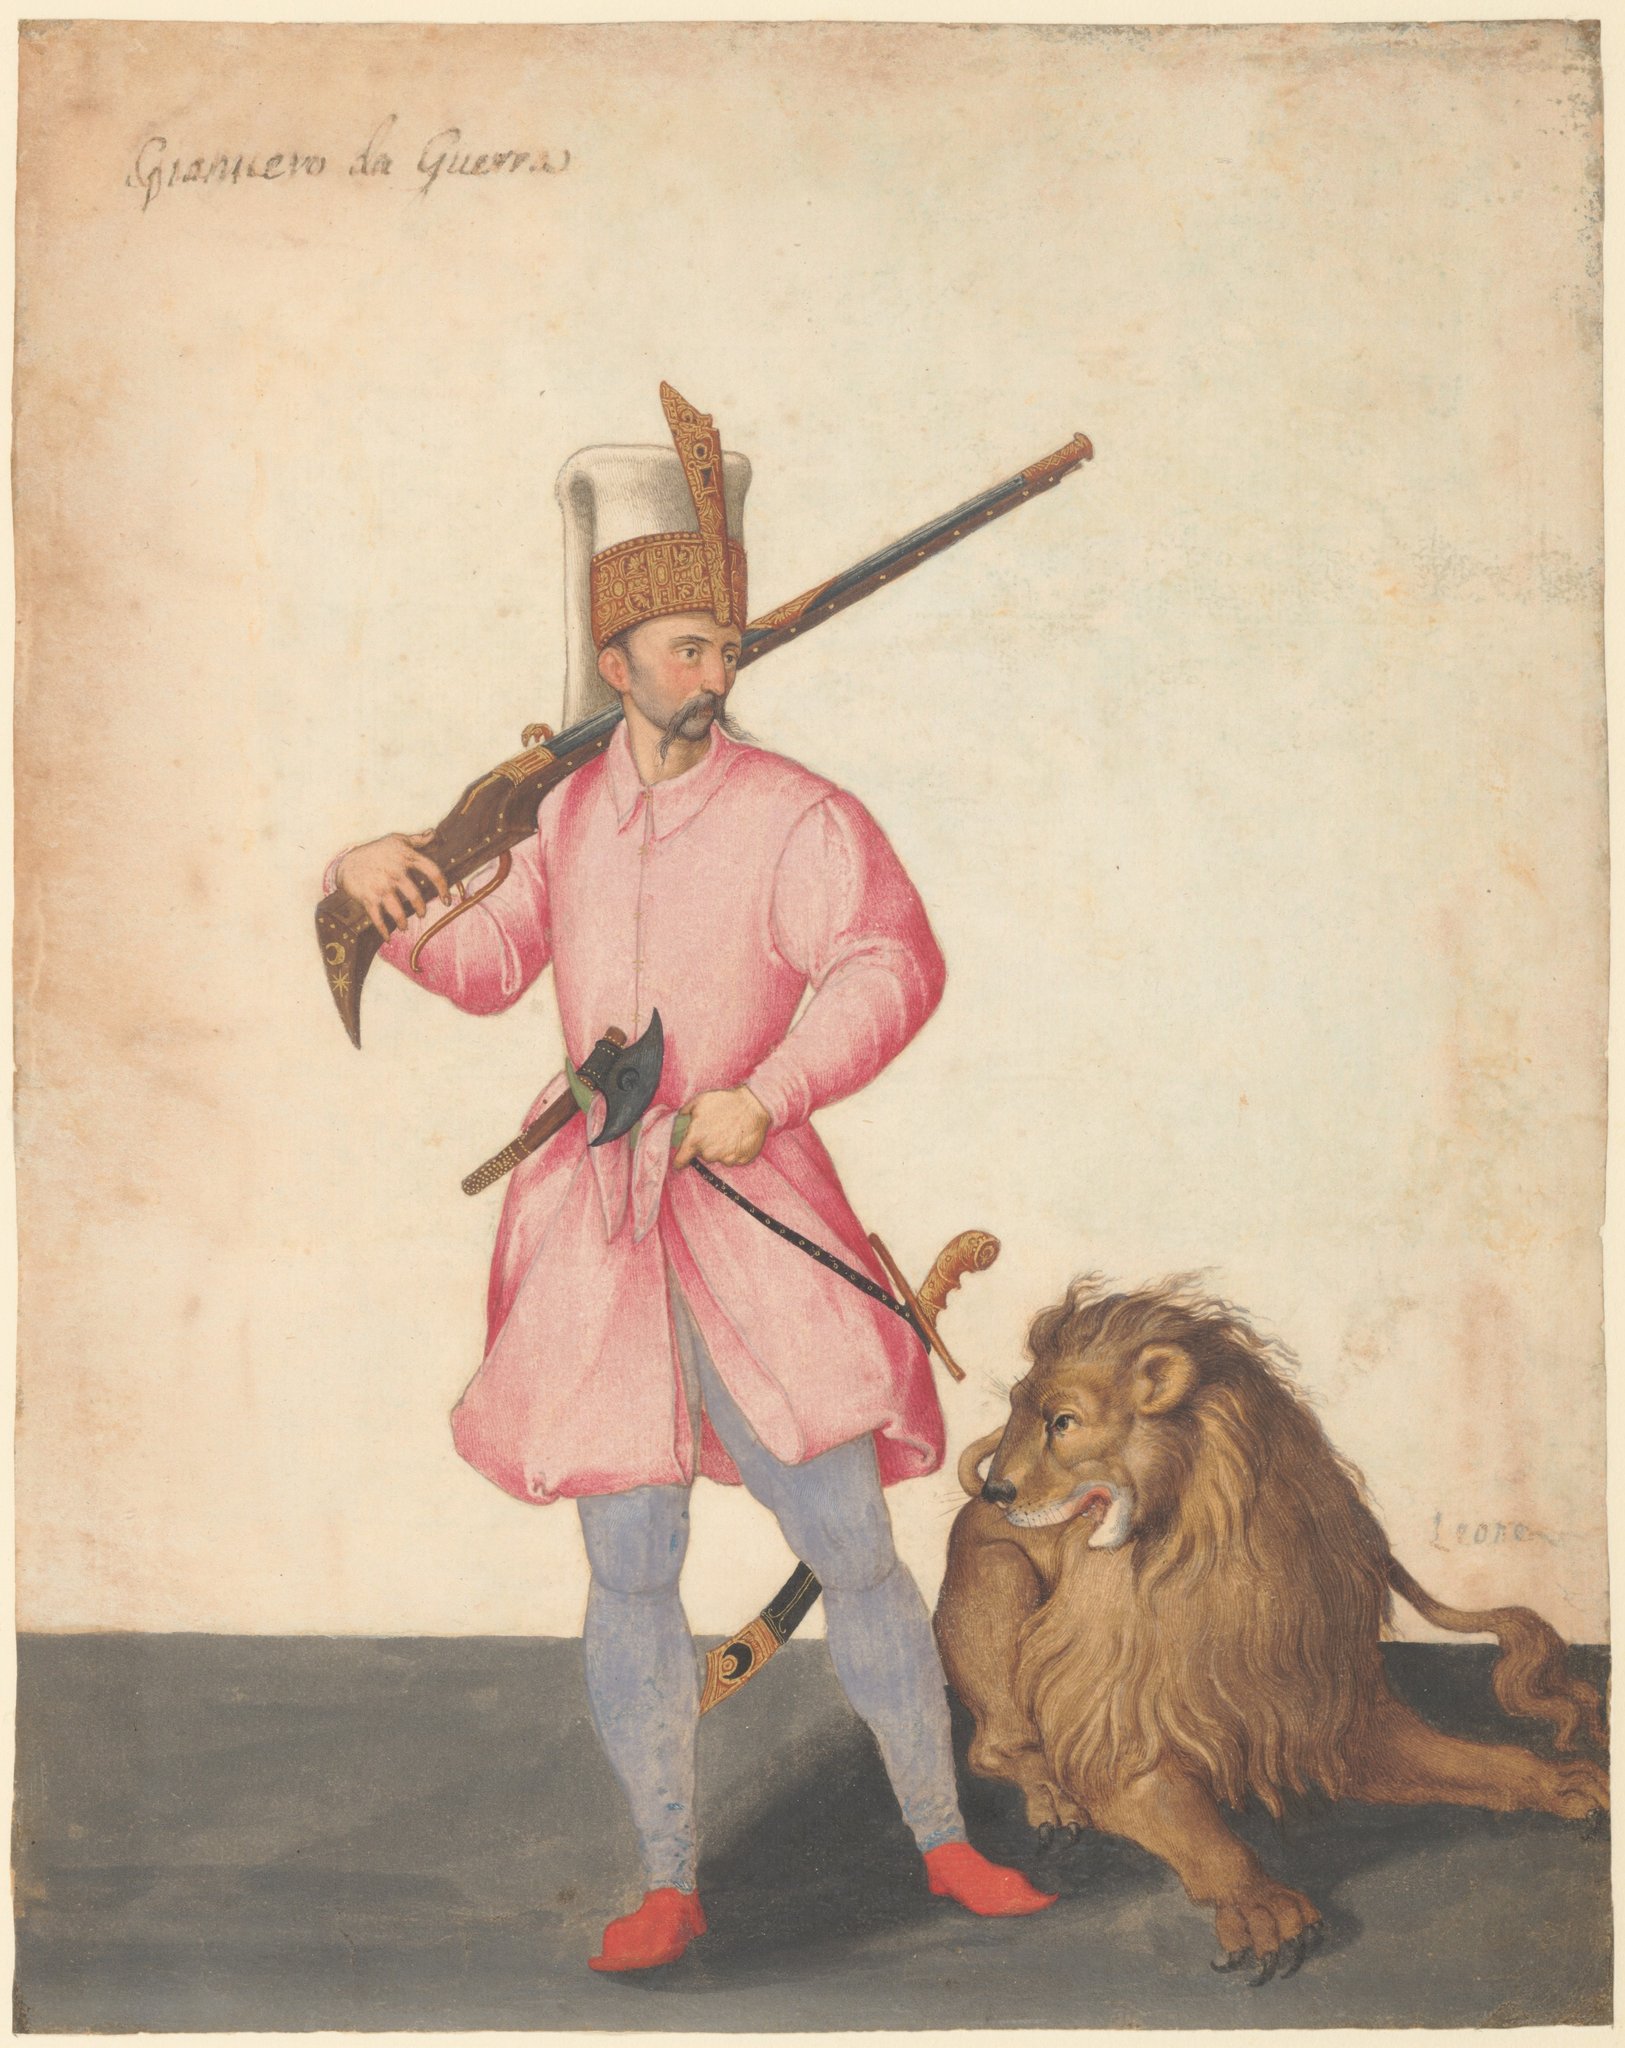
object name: drawing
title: A Janissary "of War" with a Lion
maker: jacopo ligozzi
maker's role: artist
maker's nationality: italian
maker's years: 1547-1627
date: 1577-1580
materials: gold paint, gouache, gum arabic, watercolor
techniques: burnishing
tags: firearms,men,lions